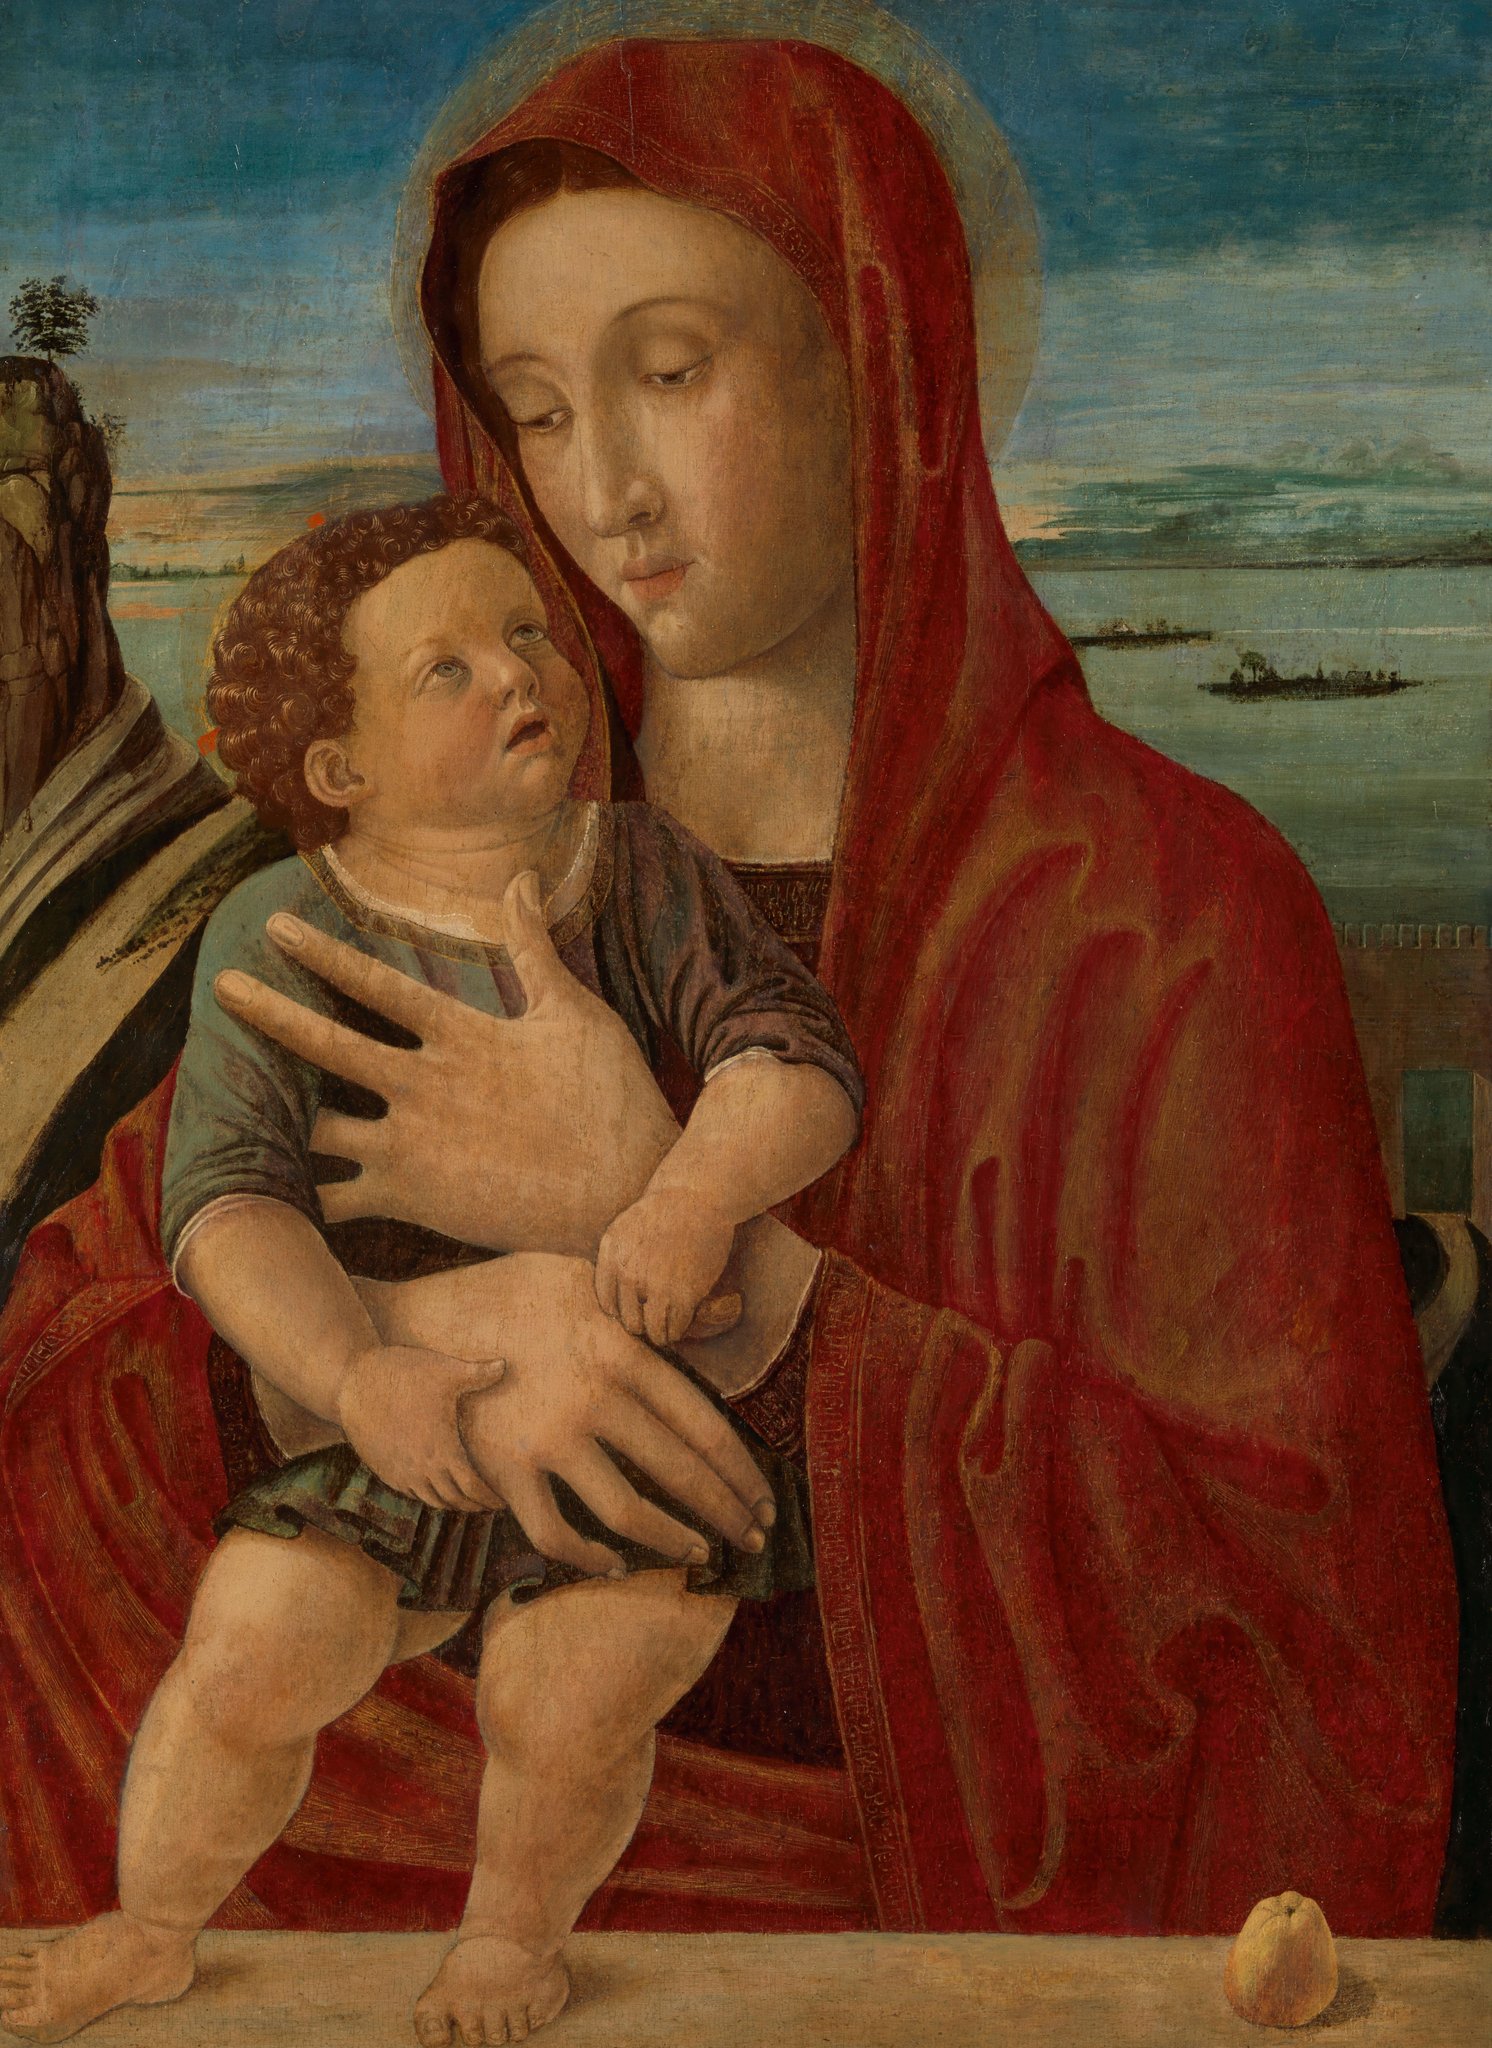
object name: painting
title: Madonna and Child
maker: giovanni bellini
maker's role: draughtsman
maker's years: 1430-1516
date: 1465-1470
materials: oil, paint, panel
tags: madonna: i.e. mary with the christ-child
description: Madonna met kind. Maria drukt het Christuskind, staande op een balustrade, tegen zich aan. Rechts een appel.